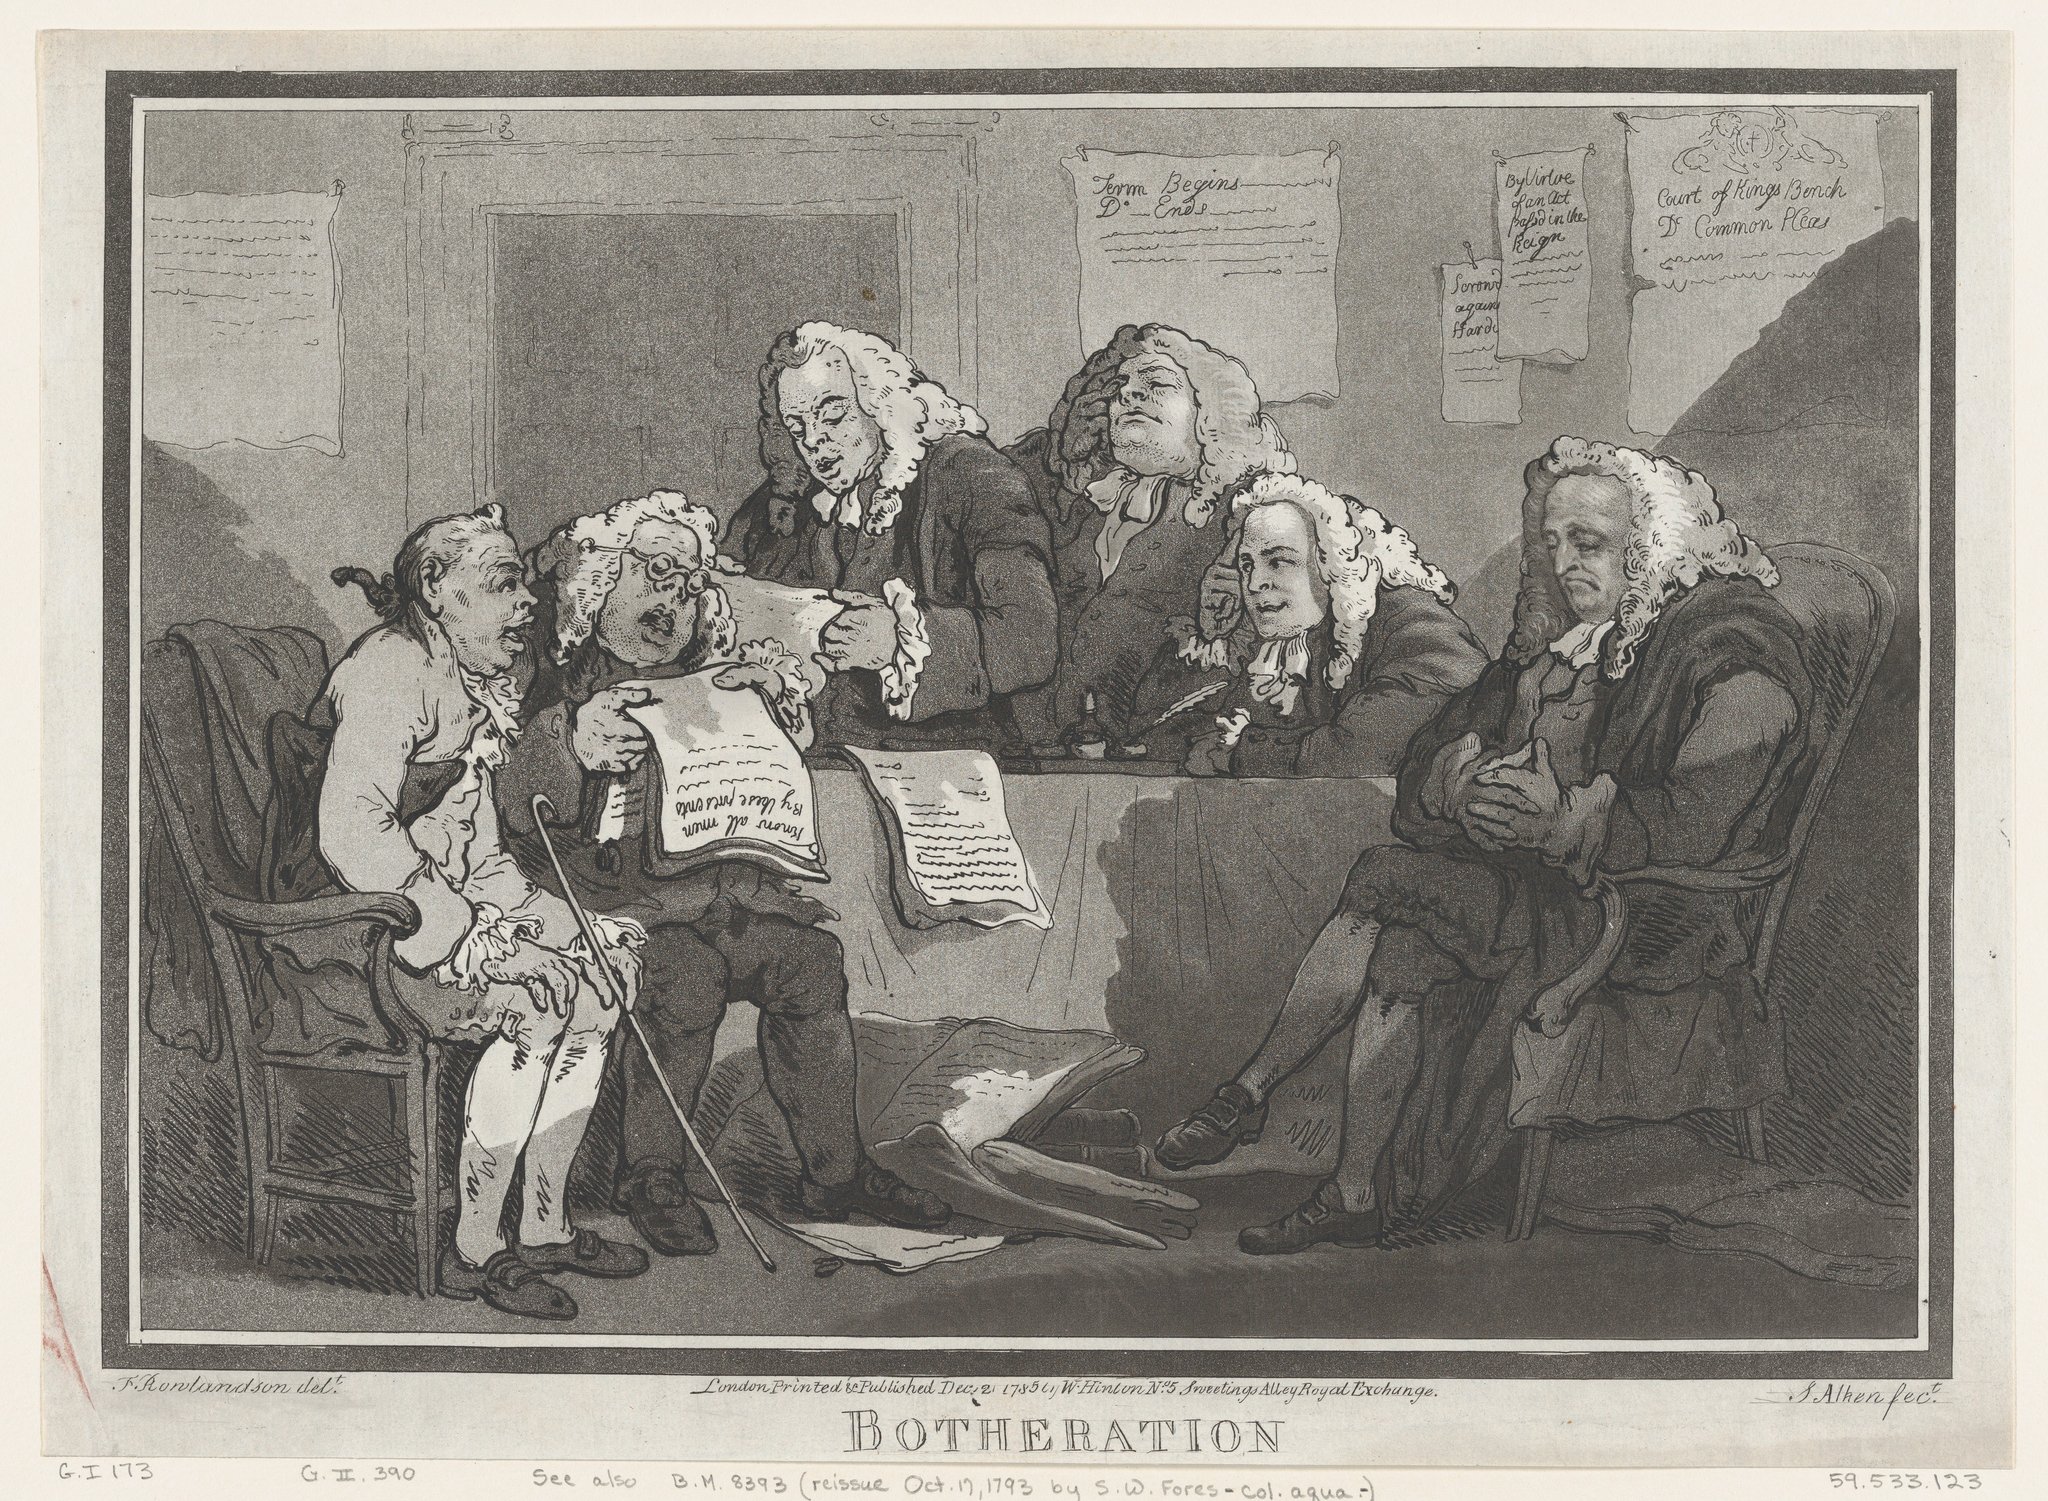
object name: print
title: Botheration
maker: samuel alken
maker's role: etcher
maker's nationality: british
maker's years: 1756-1815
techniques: etching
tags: satire,men